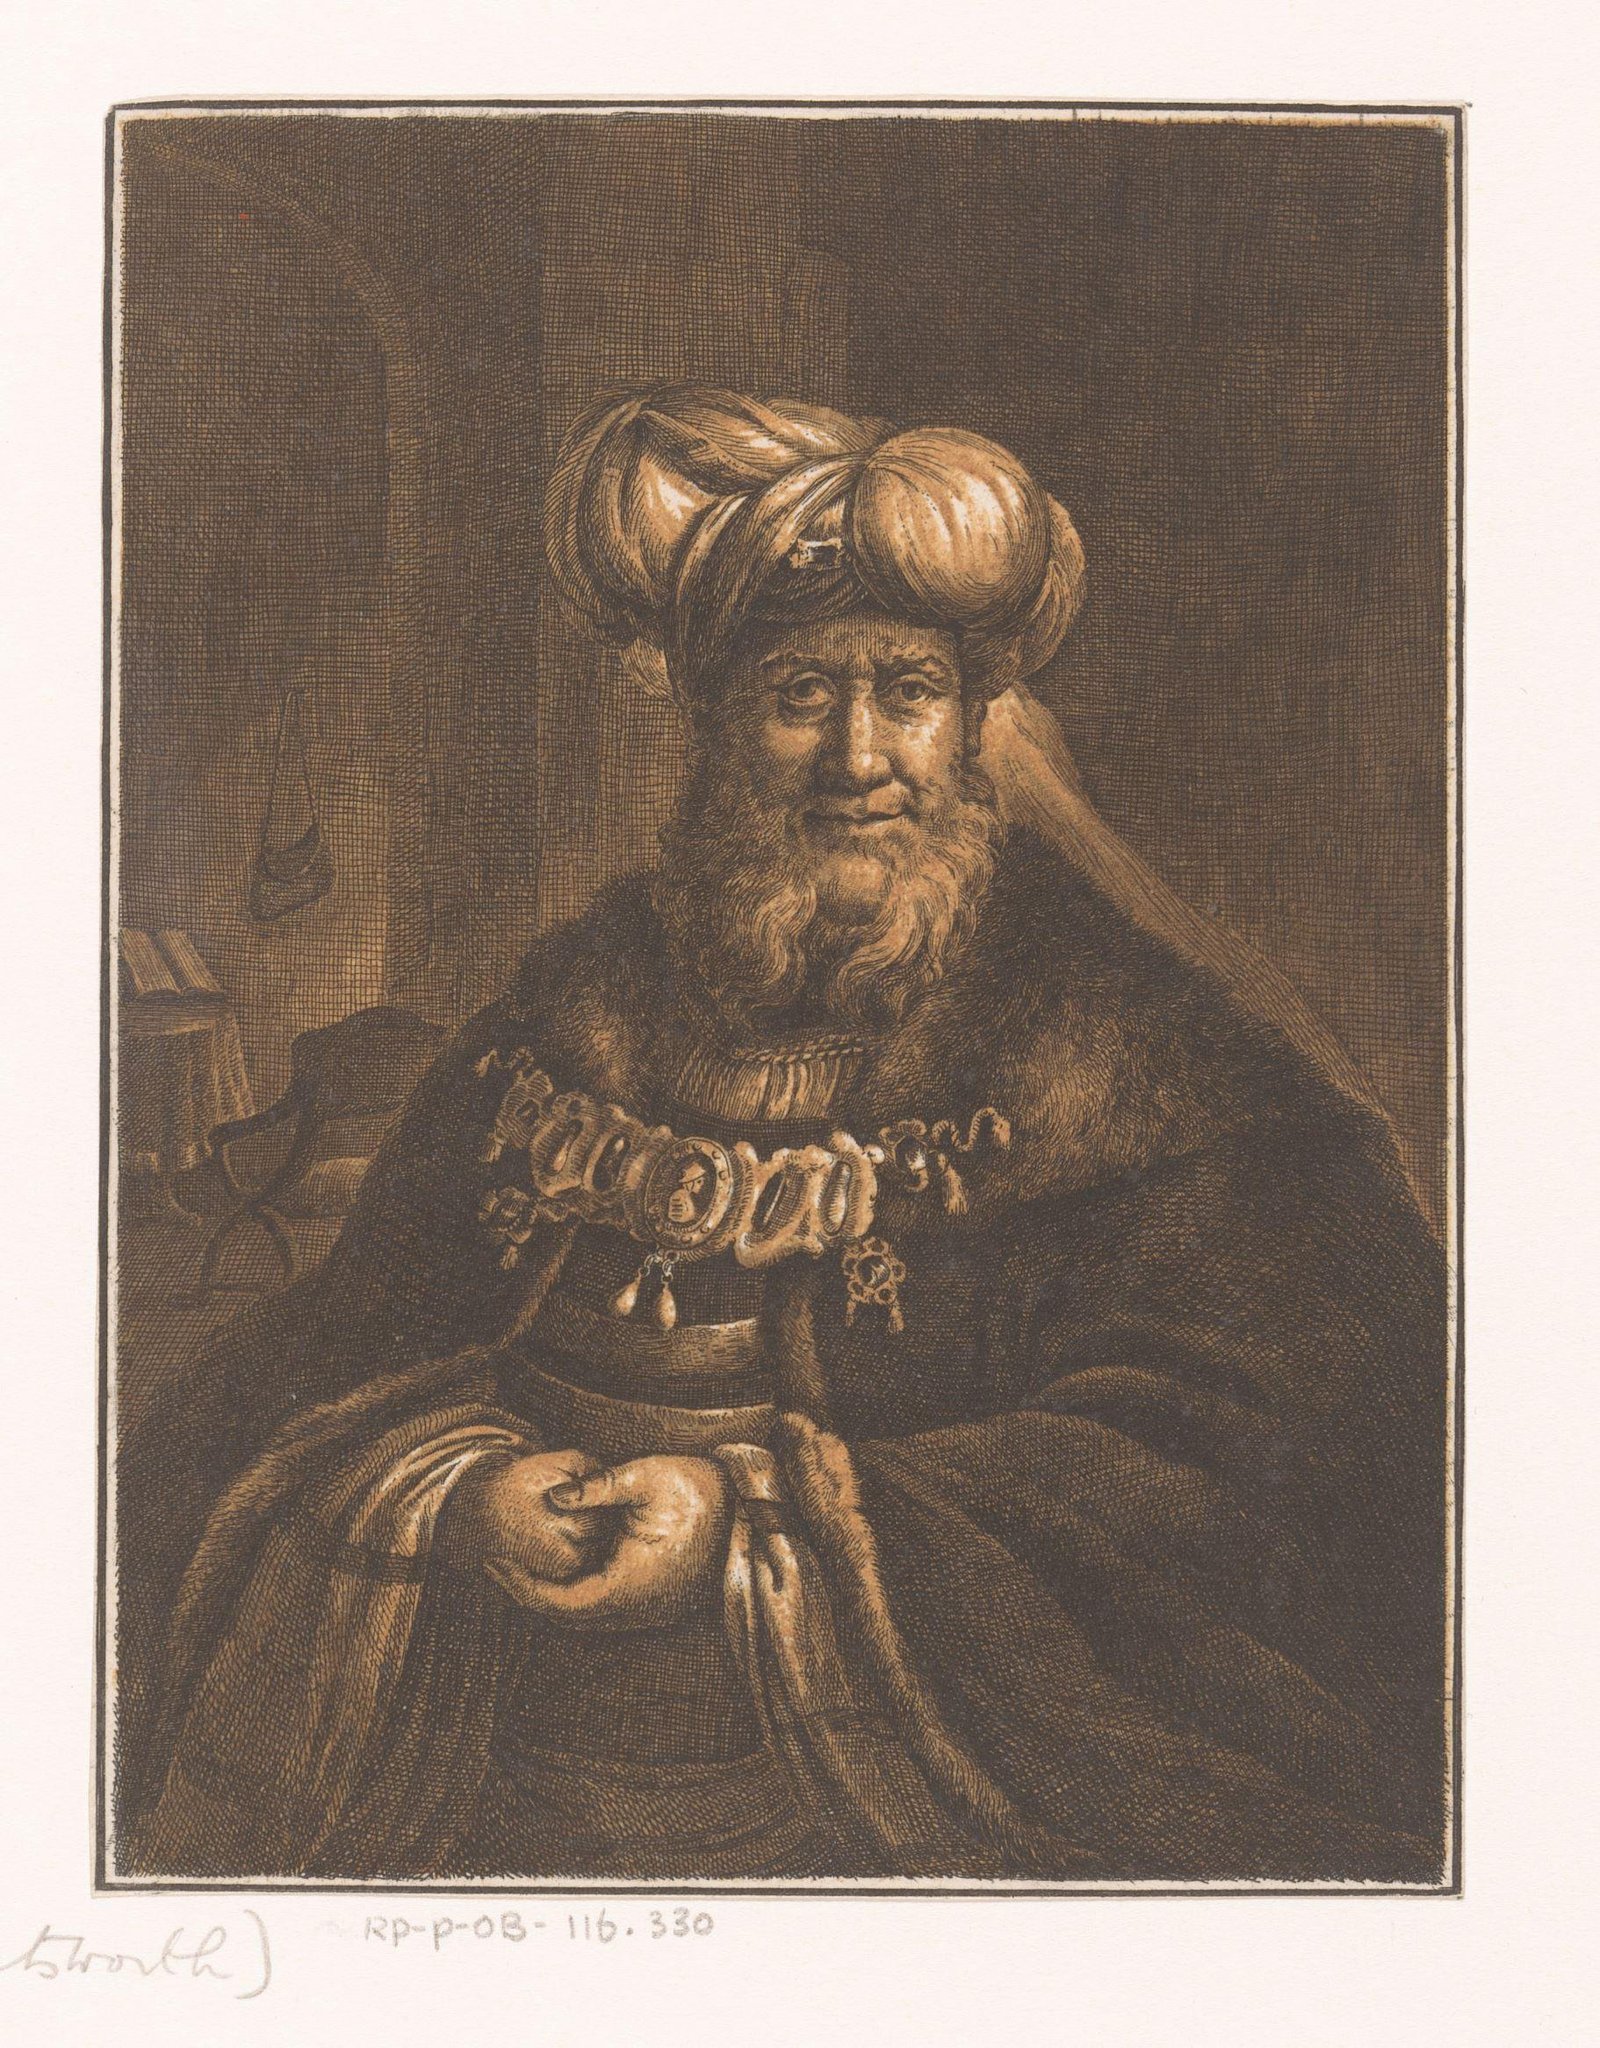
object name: print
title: Portret van een onbekende oude man met een tulband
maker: carl friedrich holtzmann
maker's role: print maker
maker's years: 1740-1811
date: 1750-1811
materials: paper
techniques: etching, intaglio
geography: dresden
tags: historical persons, male persons from the old testament (with name) (not in biblical context), head-gear: turban, historical costume, beard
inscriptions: collector's mark: Lugt 2028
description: Deze prent is vervaardigd naar het schilderij door Christian Wilhelm Ernst Dietrich (verkocht door het Keulse veilingshuis Lempertz op 18 maart 2015) dat gemaakt is naar een schilderij dat Rembrandt circa 1639 vervaardigde en zich in de Devonshire collectie van Chatsworth House (Derbyshire) bevindt. De werken zijn ook bekend onder de titel: Koning Uzzia met melaatsheid. Deze prent heeft een pendant (gelijk aan Dietrich's schilderij) dat aanwezig is in de collectie van het RMA: RP-P-1944-115.